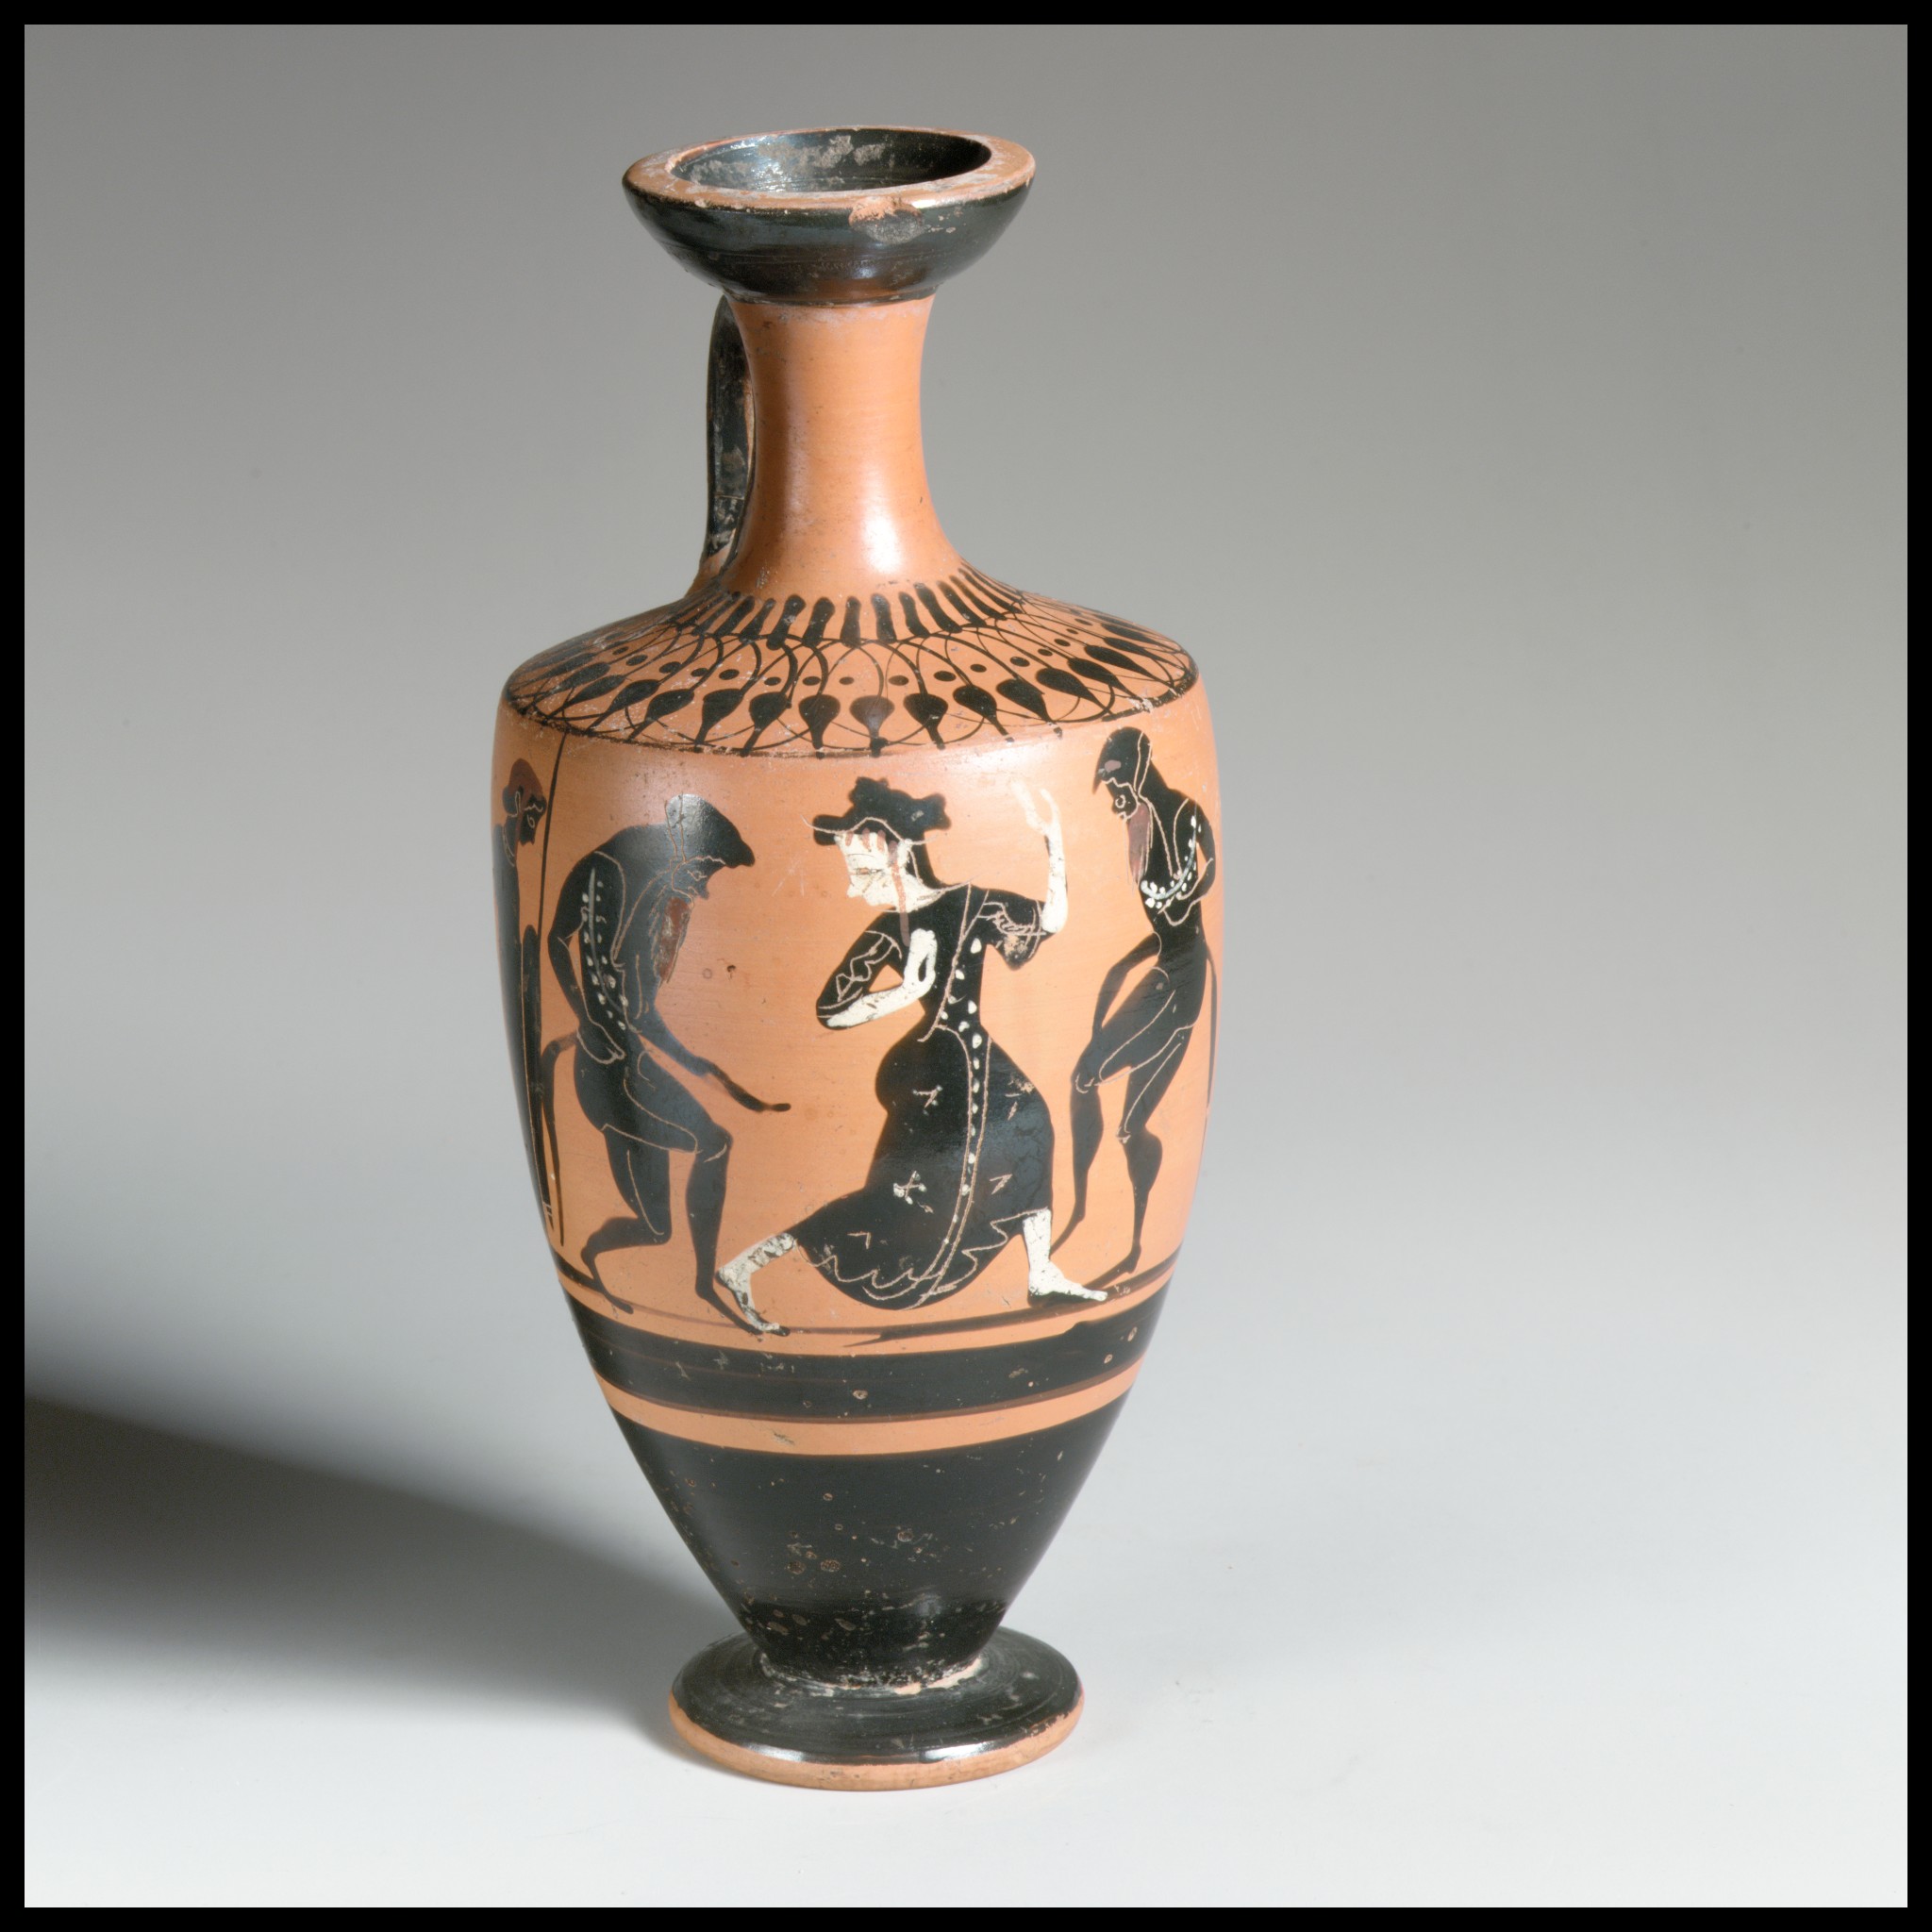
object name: lekythos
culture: greek, attic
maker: class of athens 581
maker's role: artist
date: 500-468 BCE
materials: terracotta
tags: dancing,maenads,satyrs